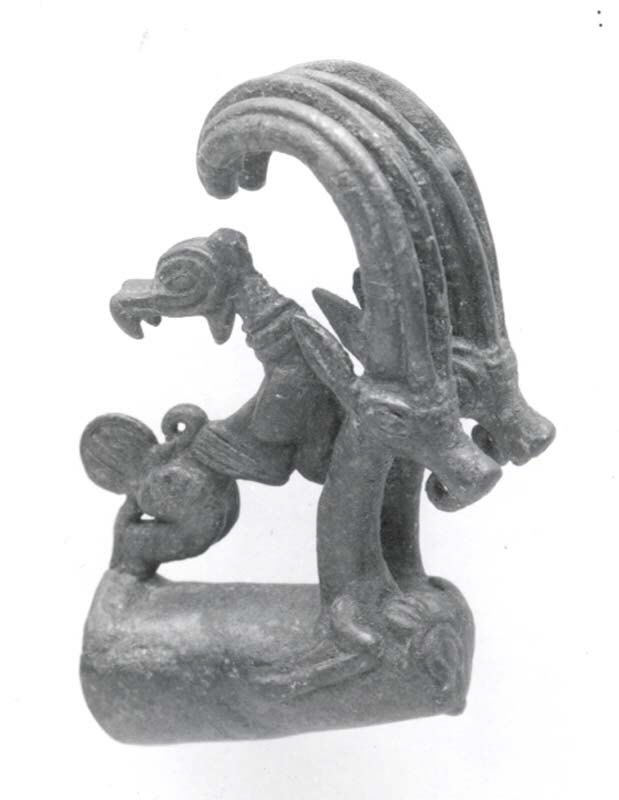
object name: whetstone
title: Whetstone handle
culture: iranian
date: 800-601 BCE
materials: bronze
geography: iran, probably from luristan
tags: animals